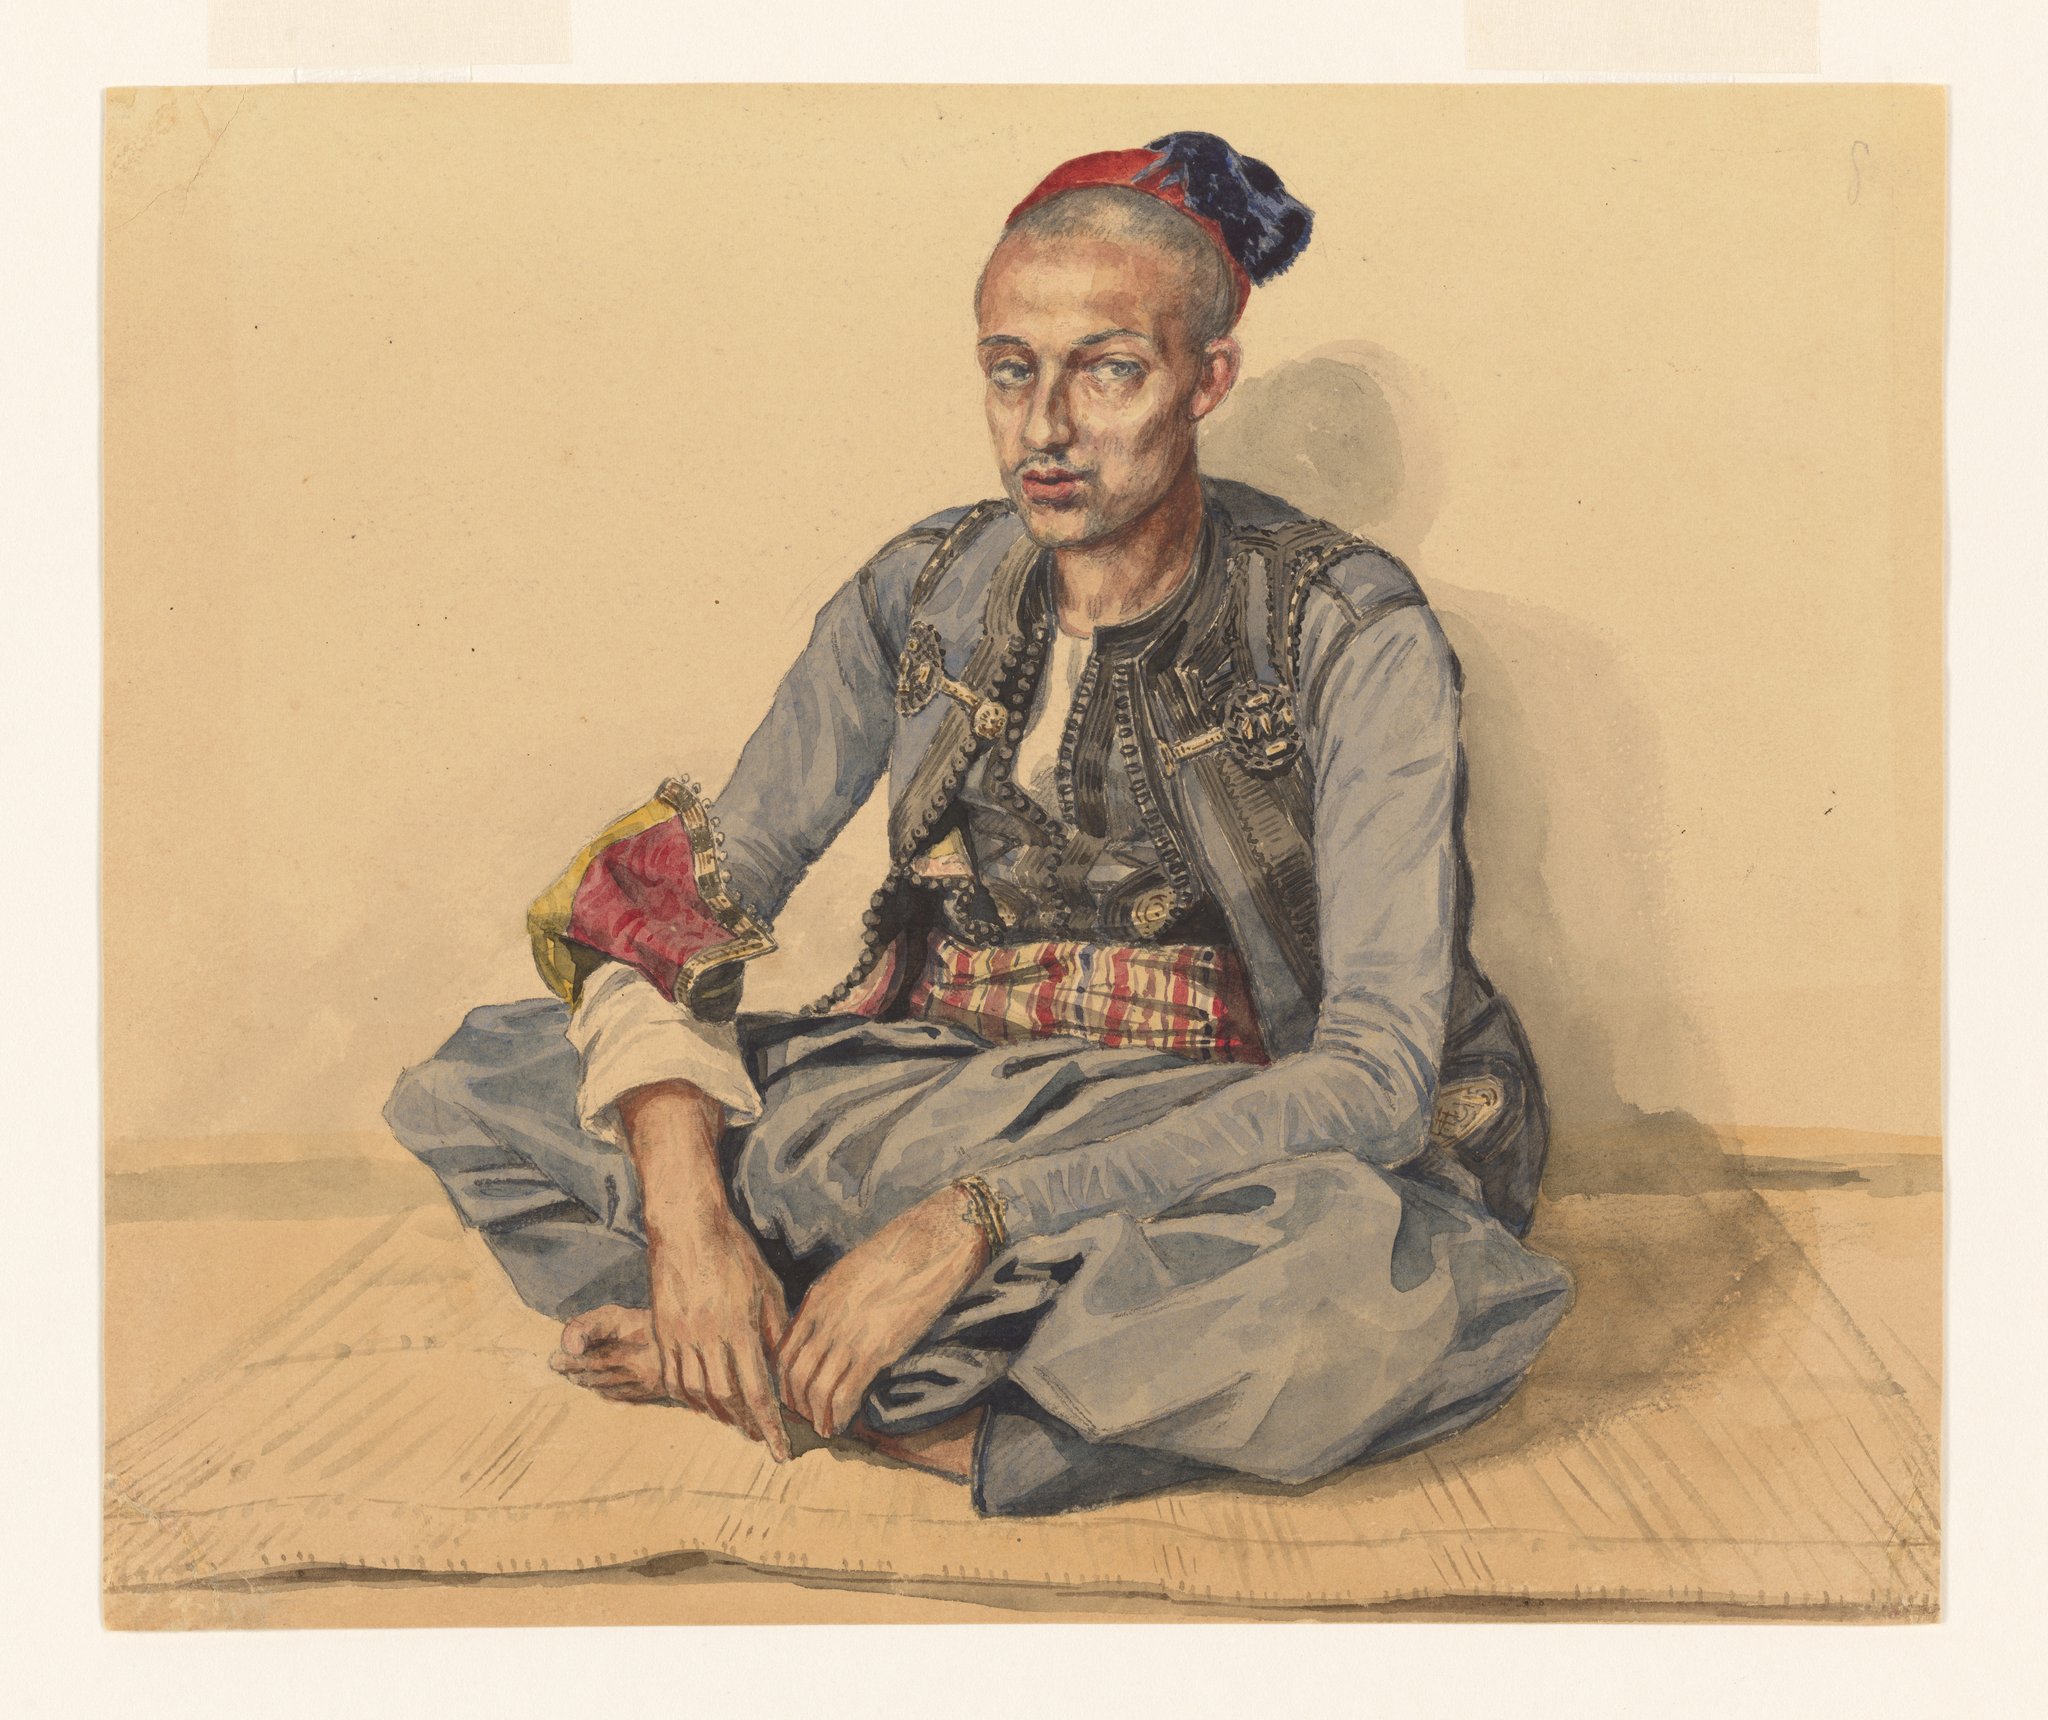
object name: drawing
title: Artisan from Algiers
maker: olivier bro de comères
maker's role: artist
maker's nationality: french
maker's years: 1813-1870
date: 1833-1840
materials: graphite, ink, watercolor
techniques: pen